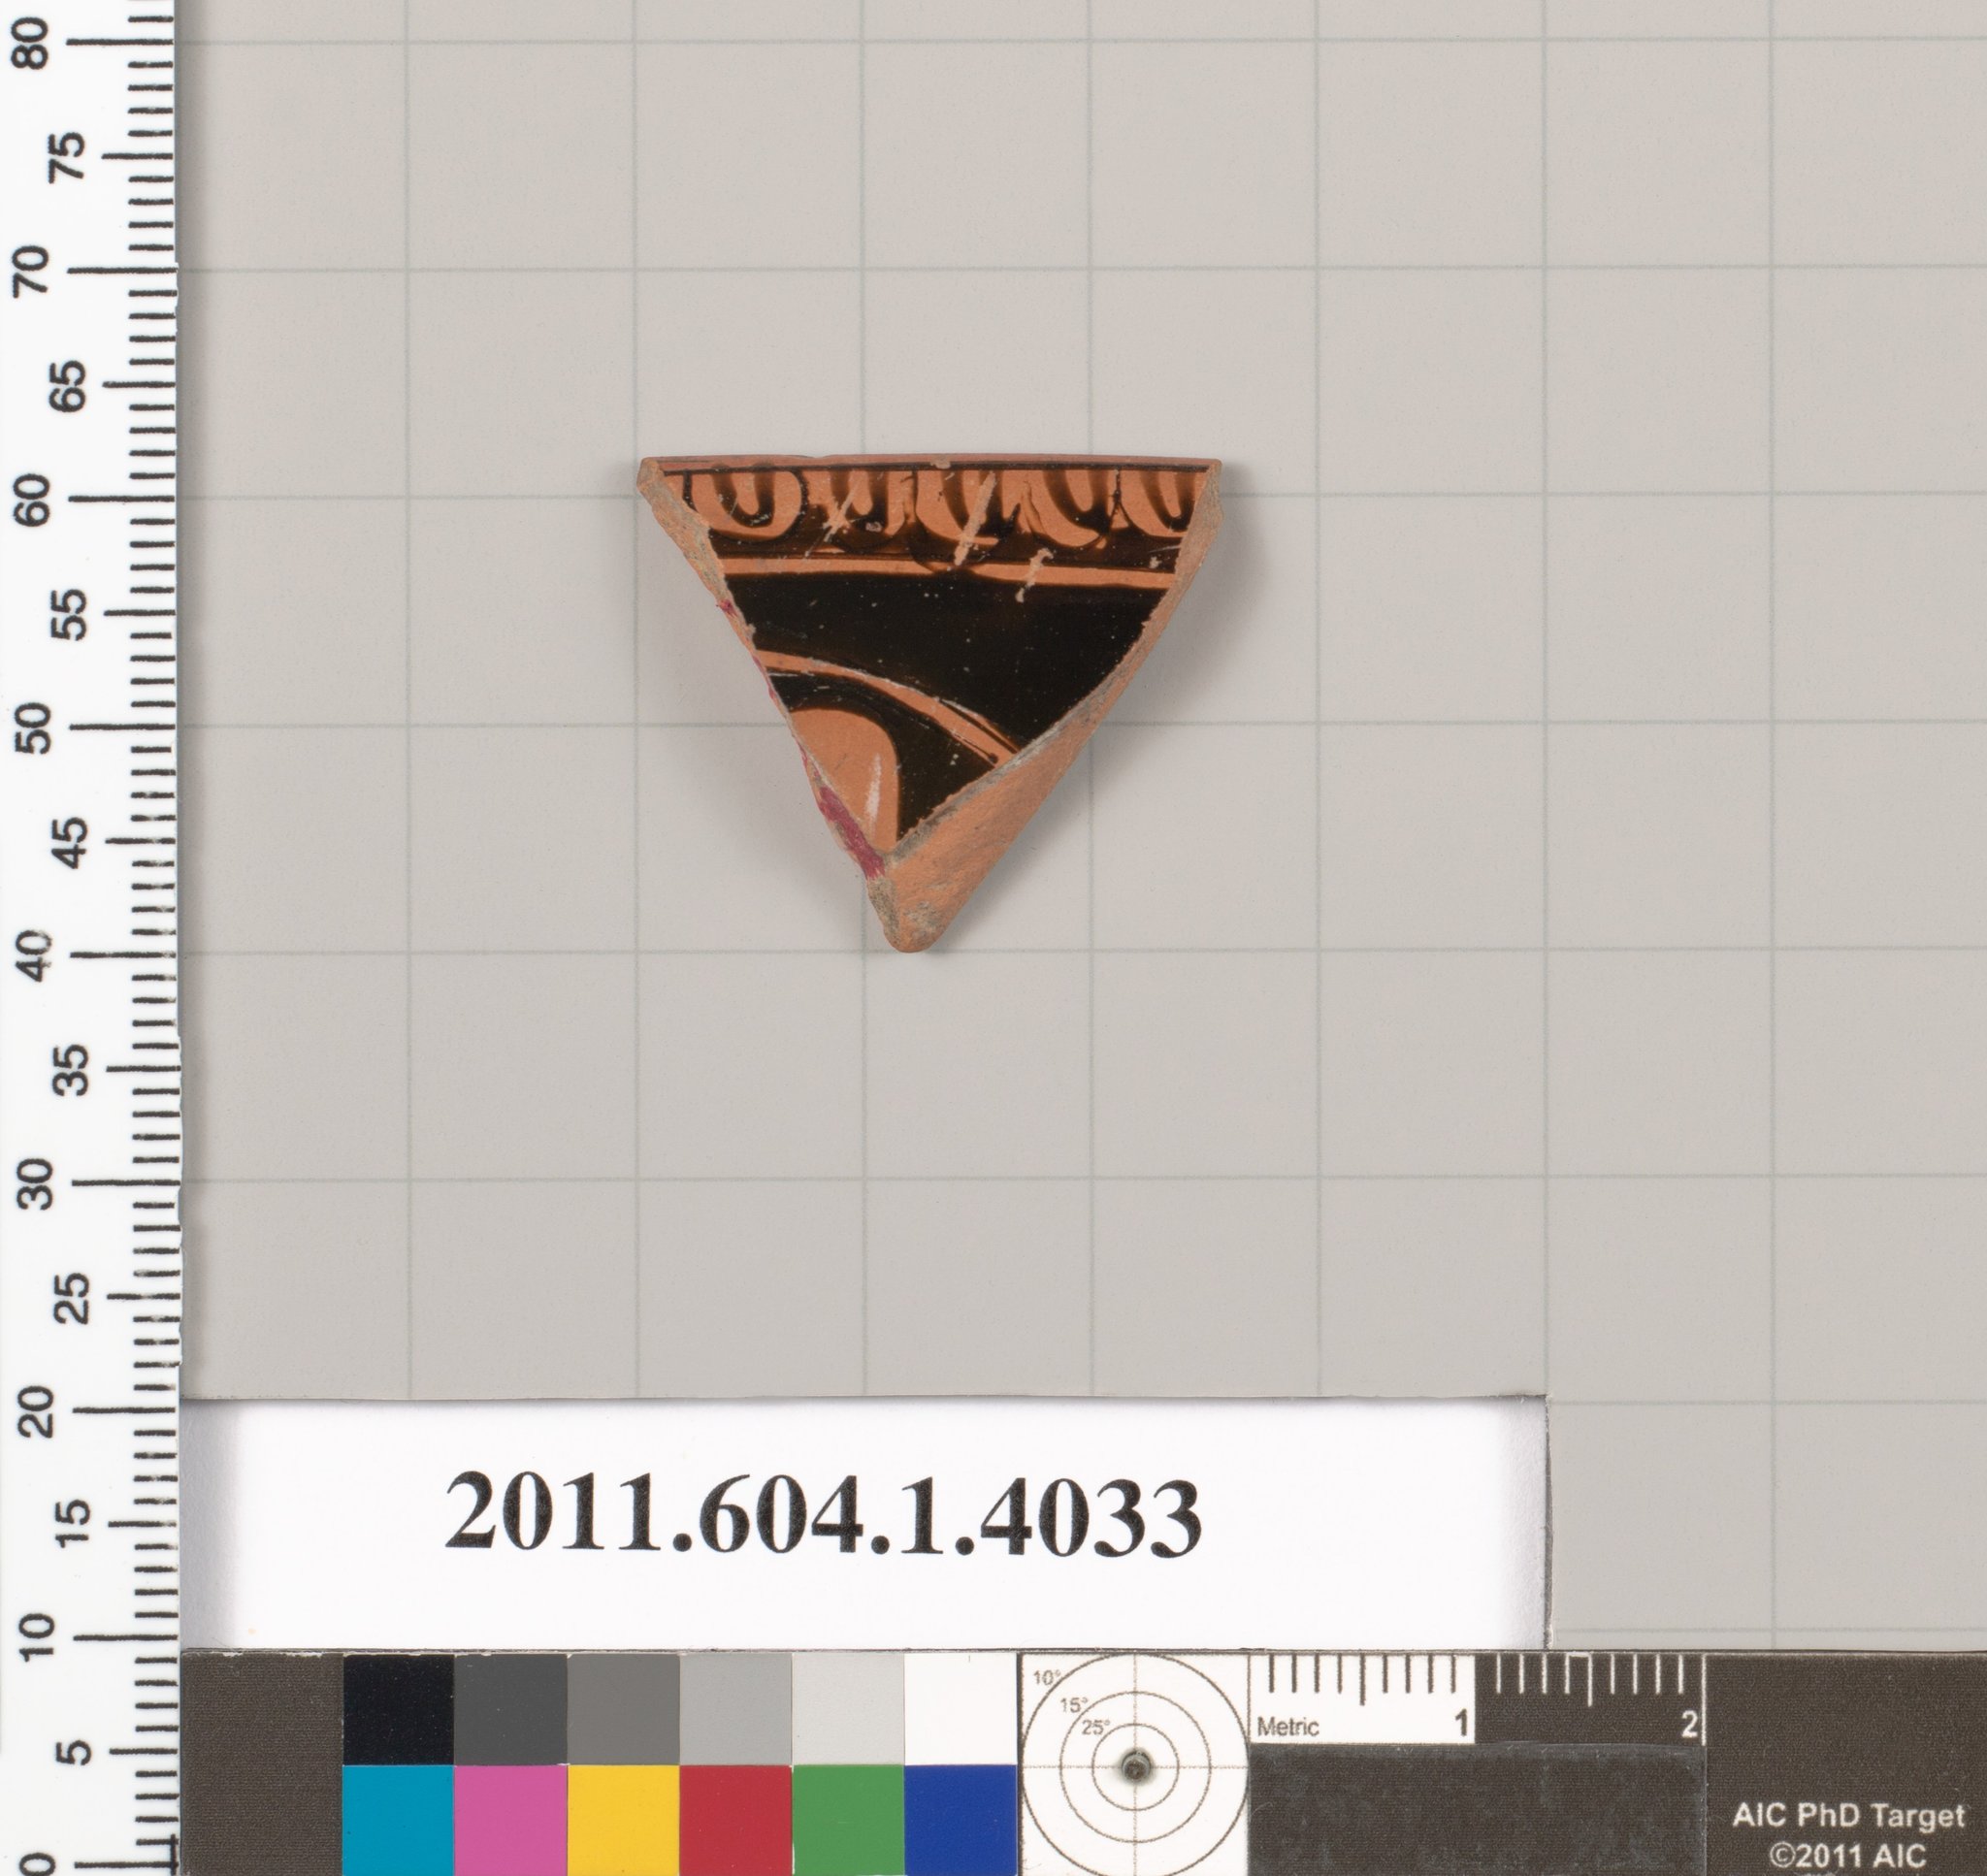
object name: kylix fragment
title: Terracotta rim fragment of a kylix (drinking cup)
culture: greek, attic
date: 460-440 BCE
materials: terracotta